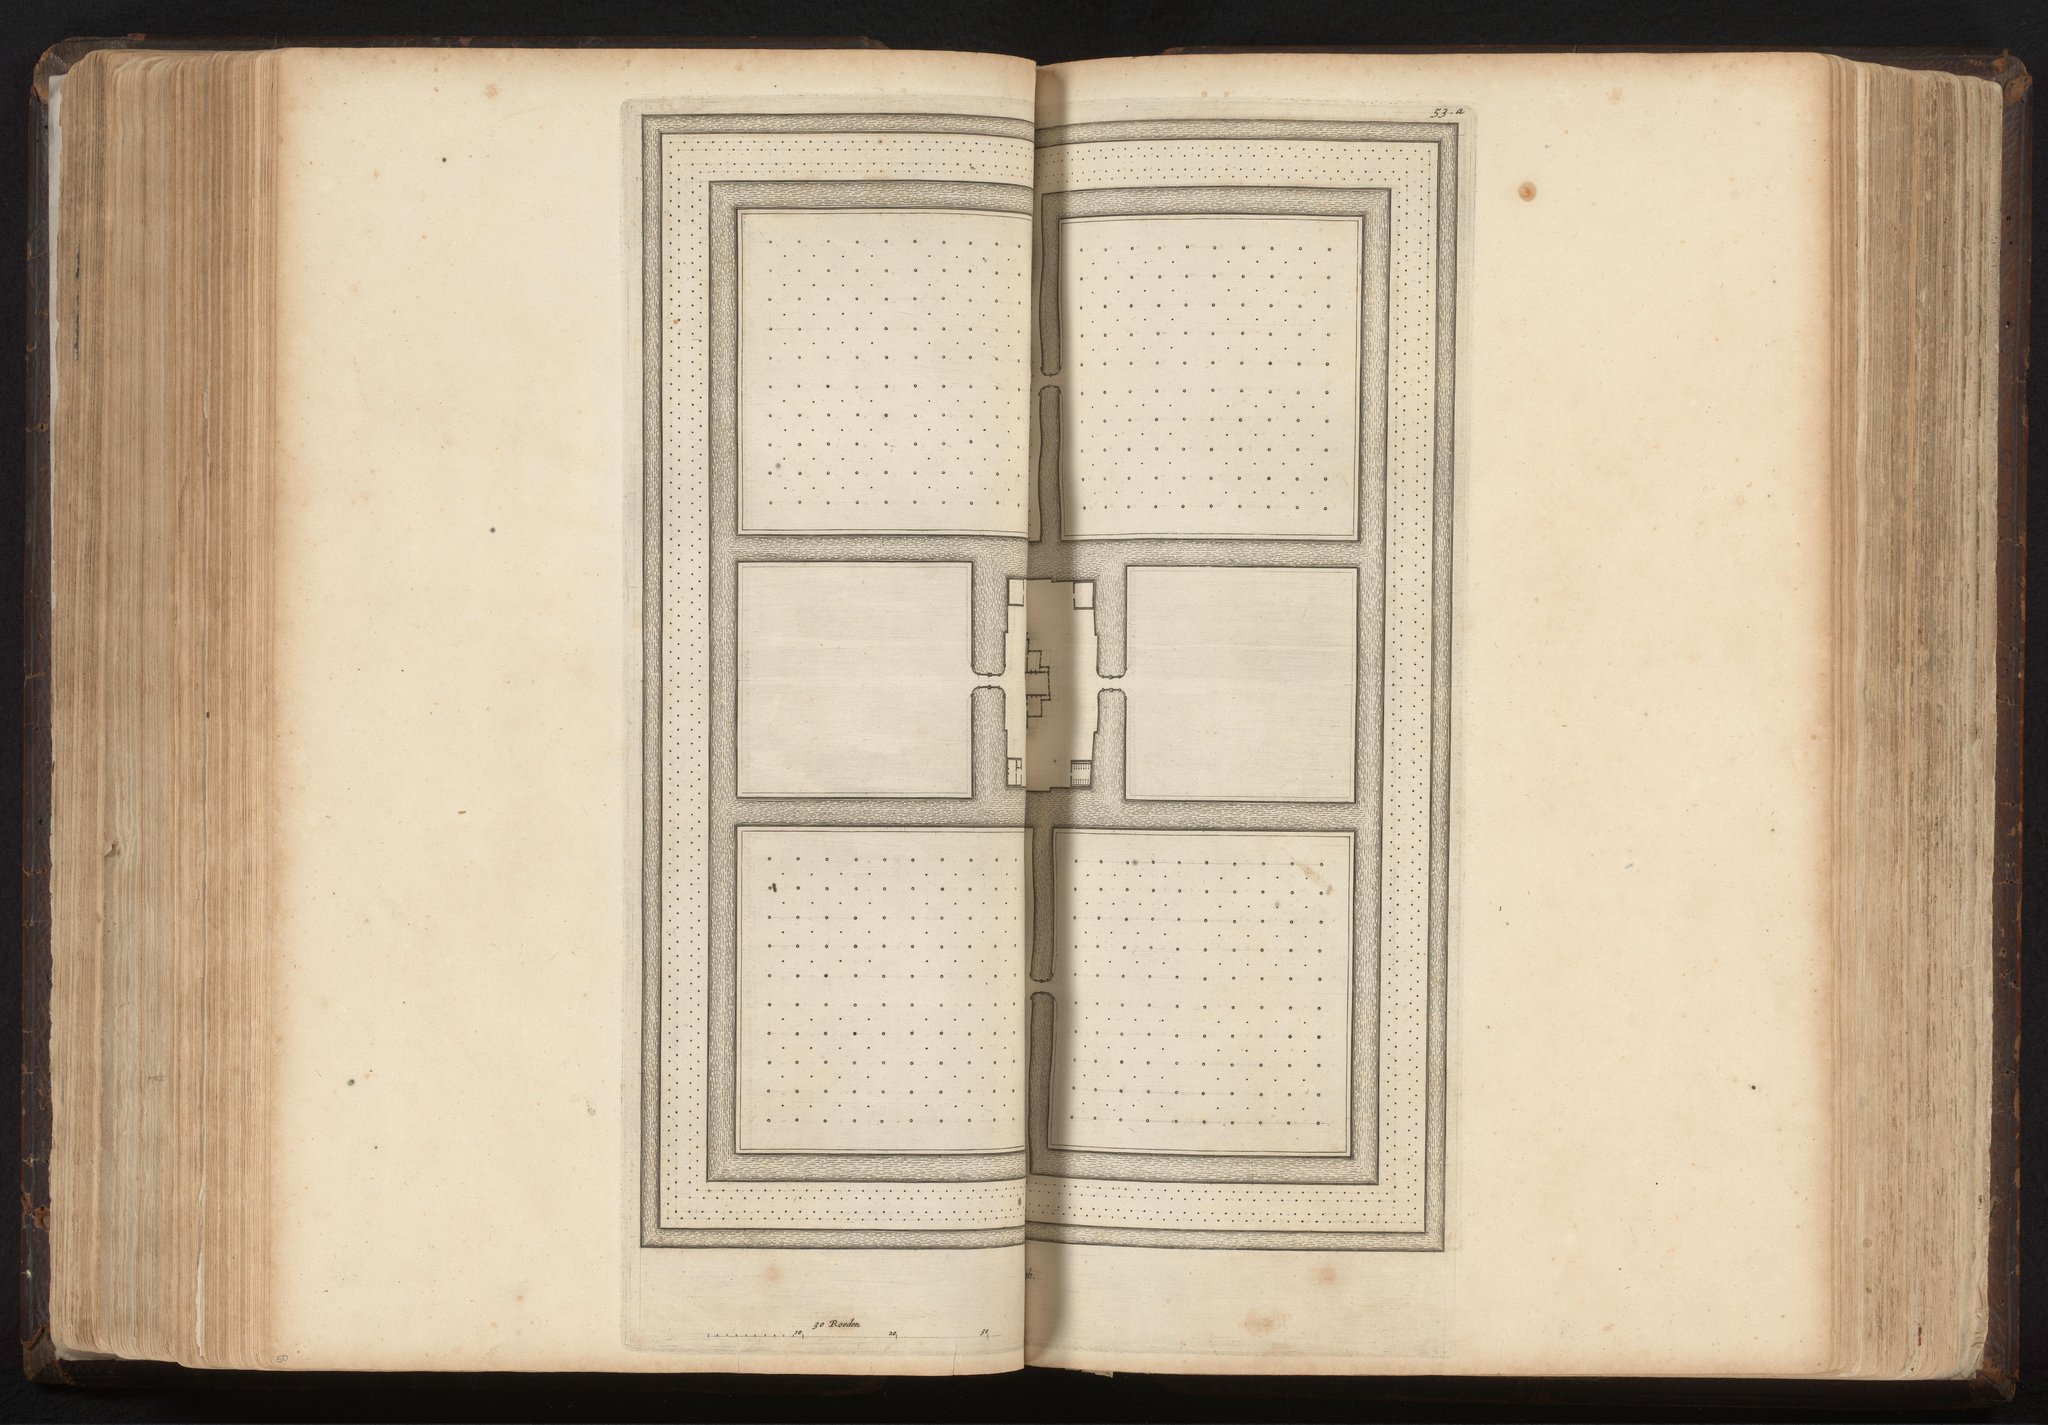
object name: print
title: Plattegrond voor een tuin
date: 1648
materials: paper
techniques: engraving, etching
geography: amsterdam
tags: plan, map of garden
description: Prent uit: Afbeelsels der voornaemste gebouwen uyt alle die Philips Vingboons geordineert heeft. Amsterdam: Philips en Johannes Vinckboons en Johannes Willemszoon Blaeu, 1648.